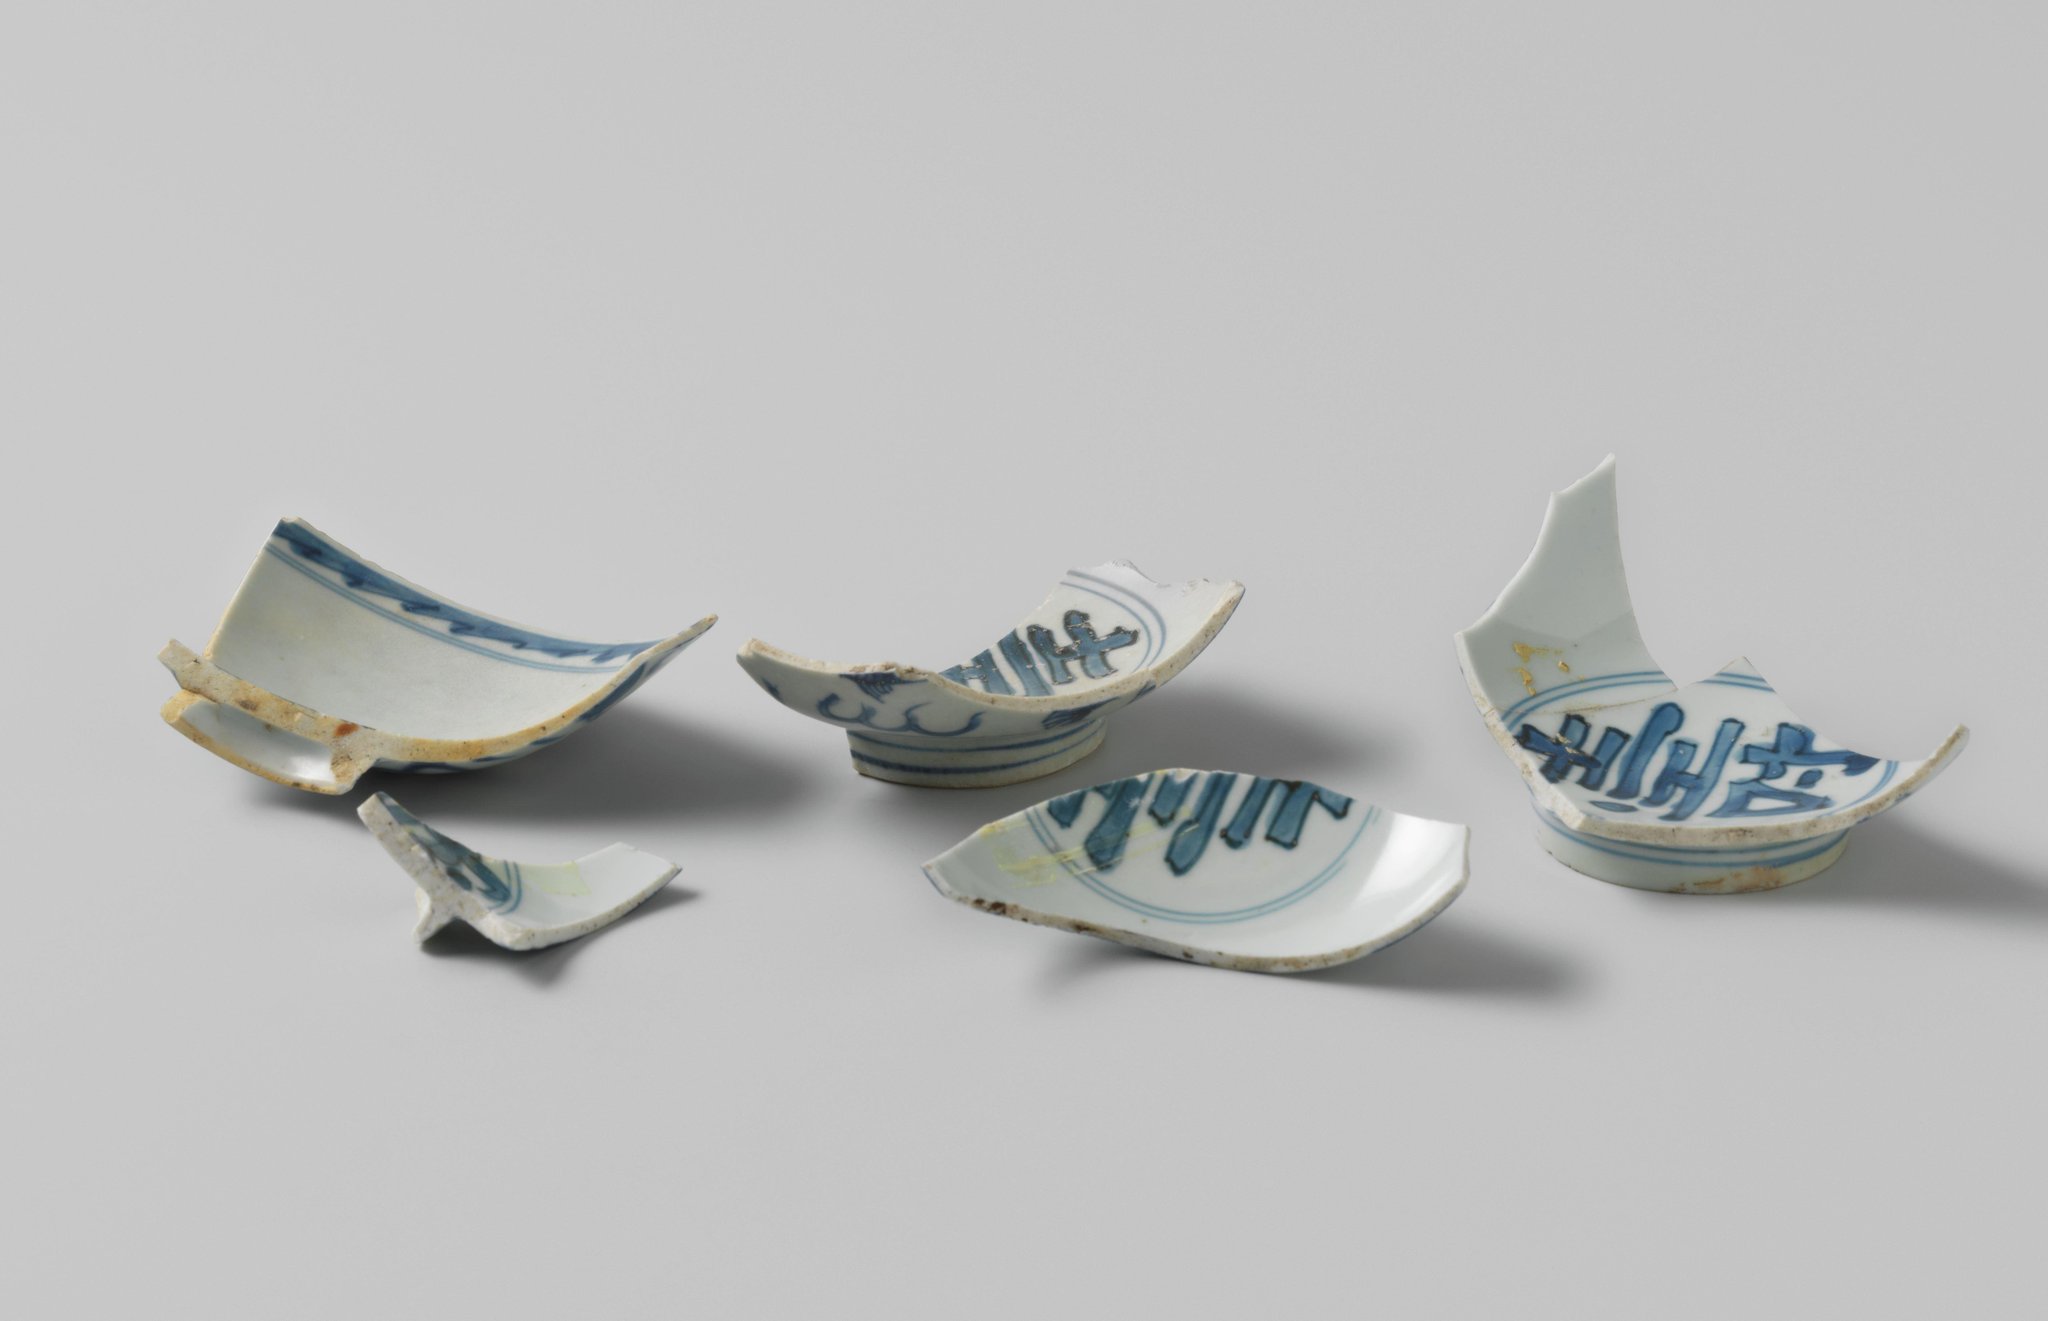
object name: sherd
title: Fragmenten van kommen uit V.O.C.-schip de 'Witte Leeuw'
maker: Anonymous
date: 1613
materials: porcelain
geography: jingdezhen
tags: verenigde oostindische compagnie, sint-helena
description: Fragmenten van kommen uit V.O.C.-schip de 'Witte Leeuw'. Bodemfragmenten.